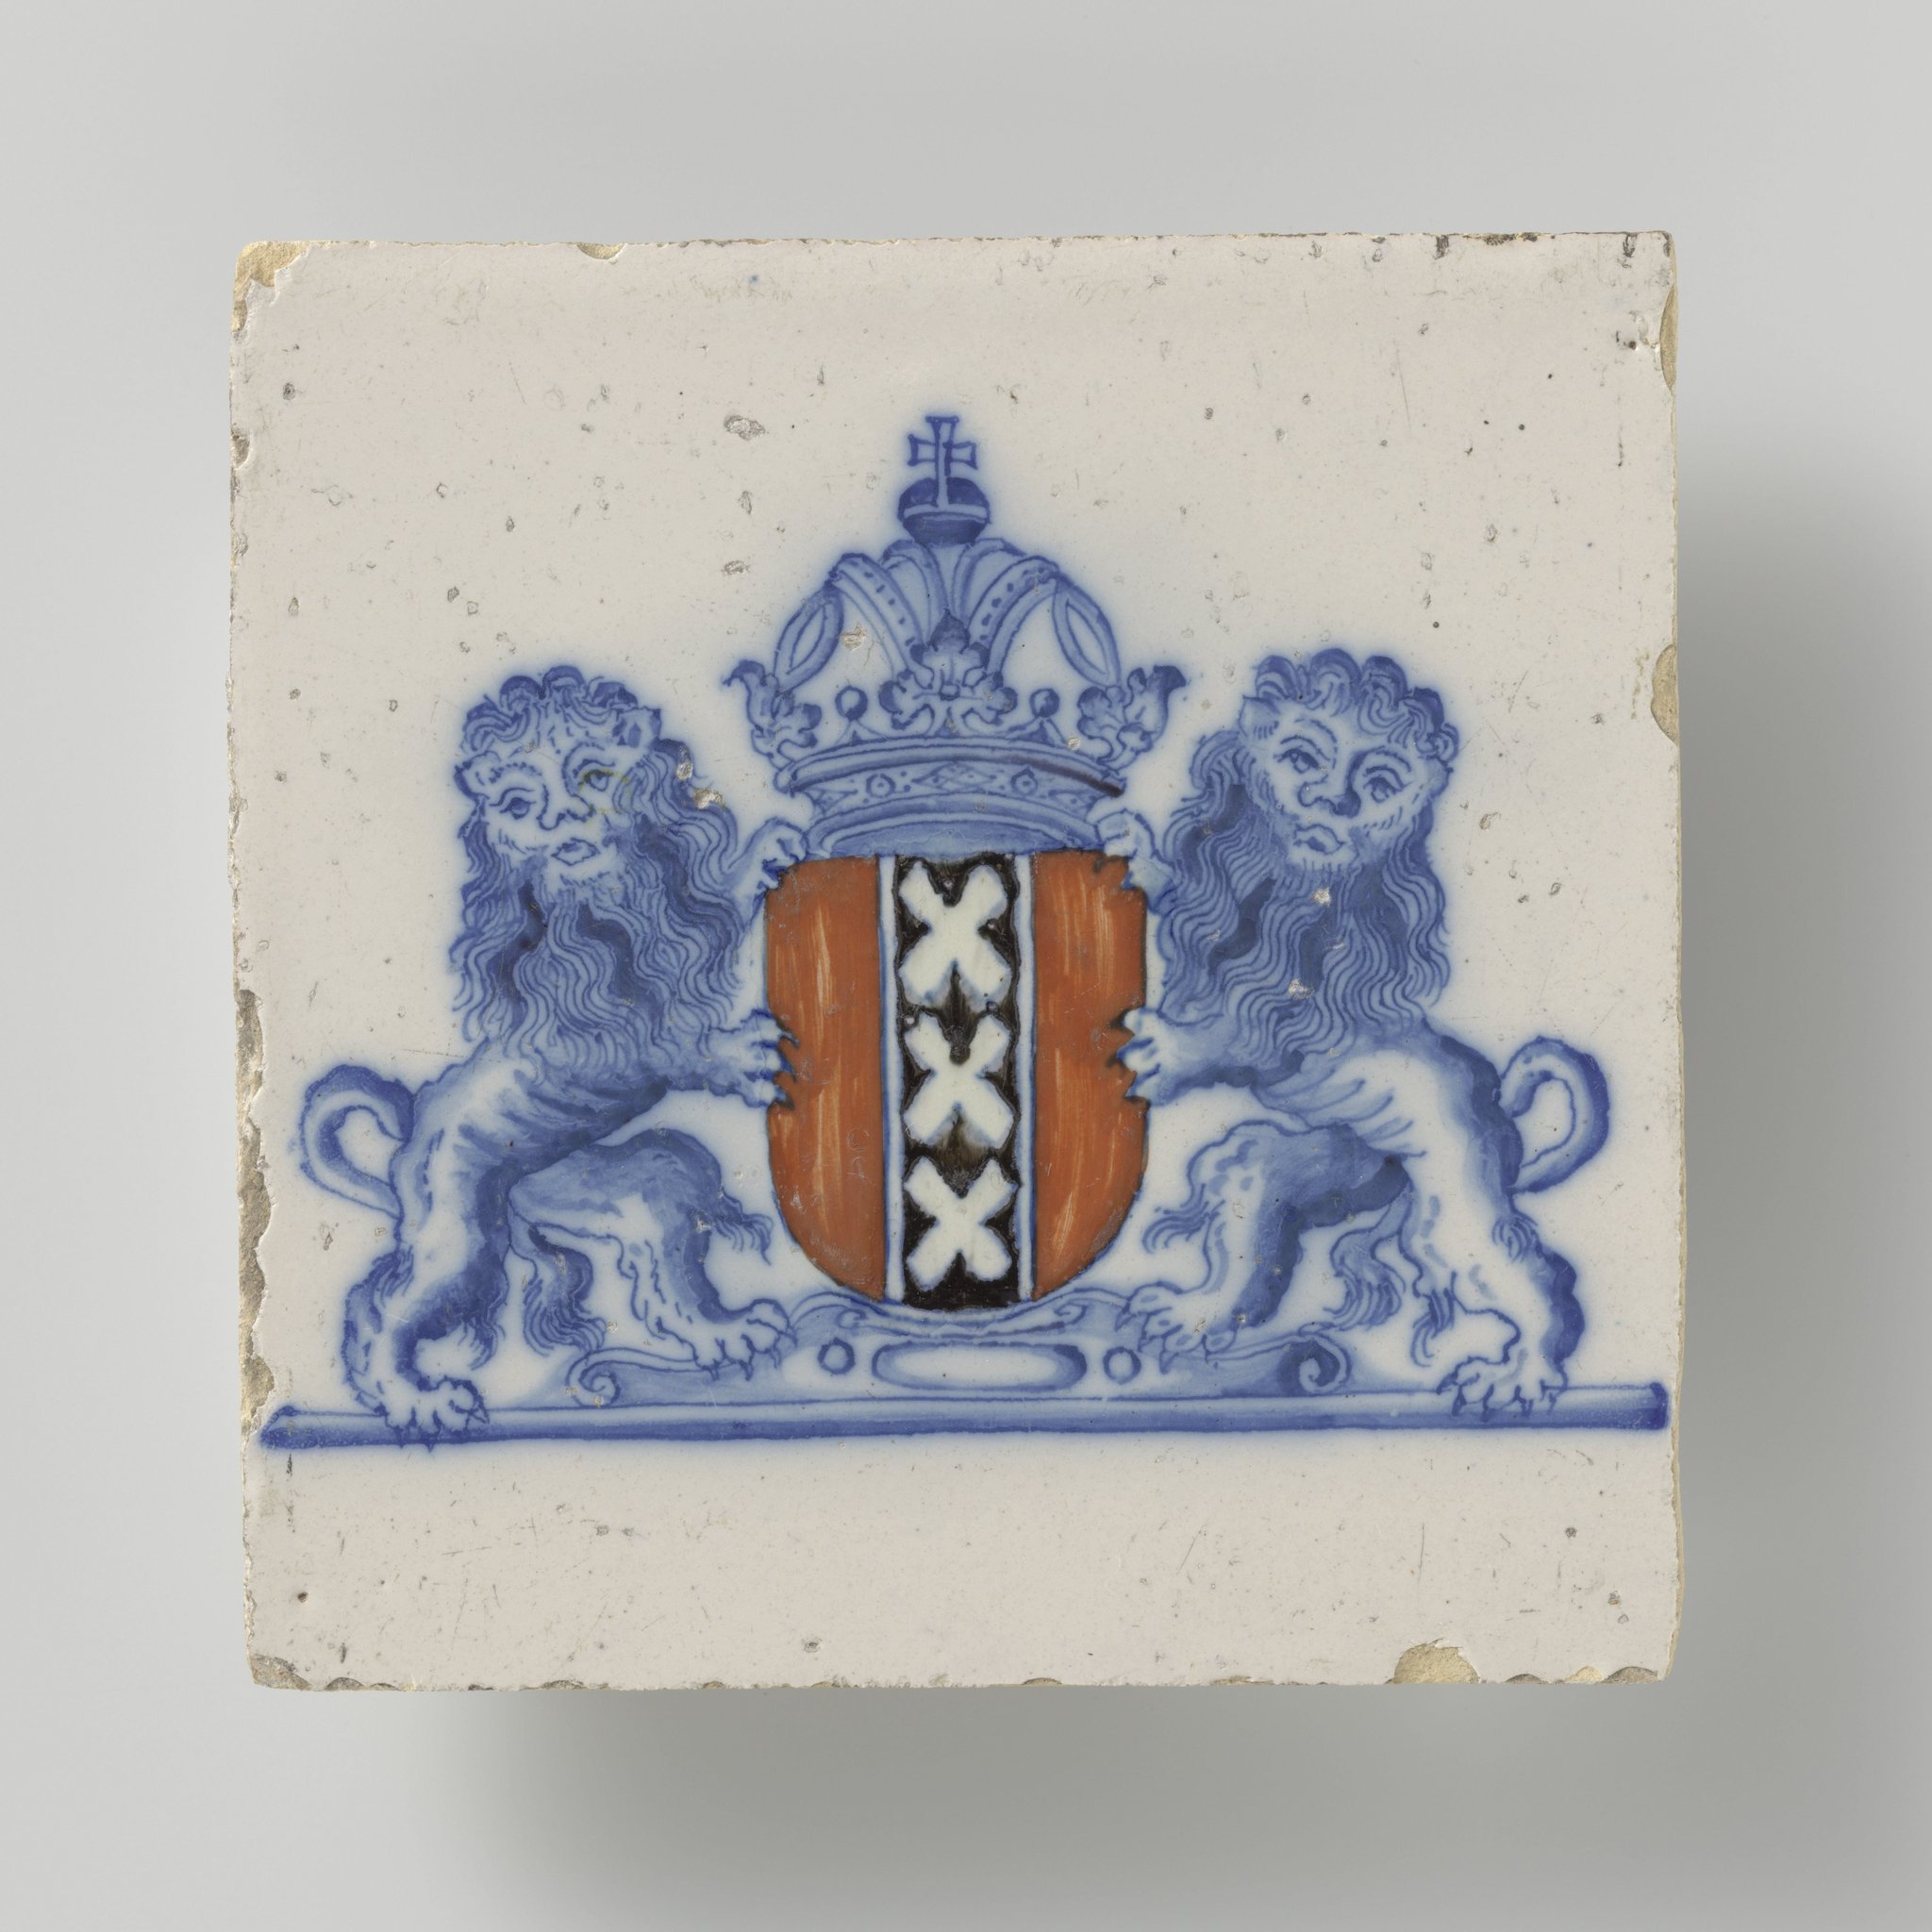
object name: tile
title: Tegel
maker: Anonymous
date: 1720-1760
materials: earthenware, glaze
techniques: maiolica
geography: amsterdam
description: Tegel met een veelkleurig (rood, zwart en blauw) geschilderd stadswapen van Amsterdam geflankeerd door leeuwen.